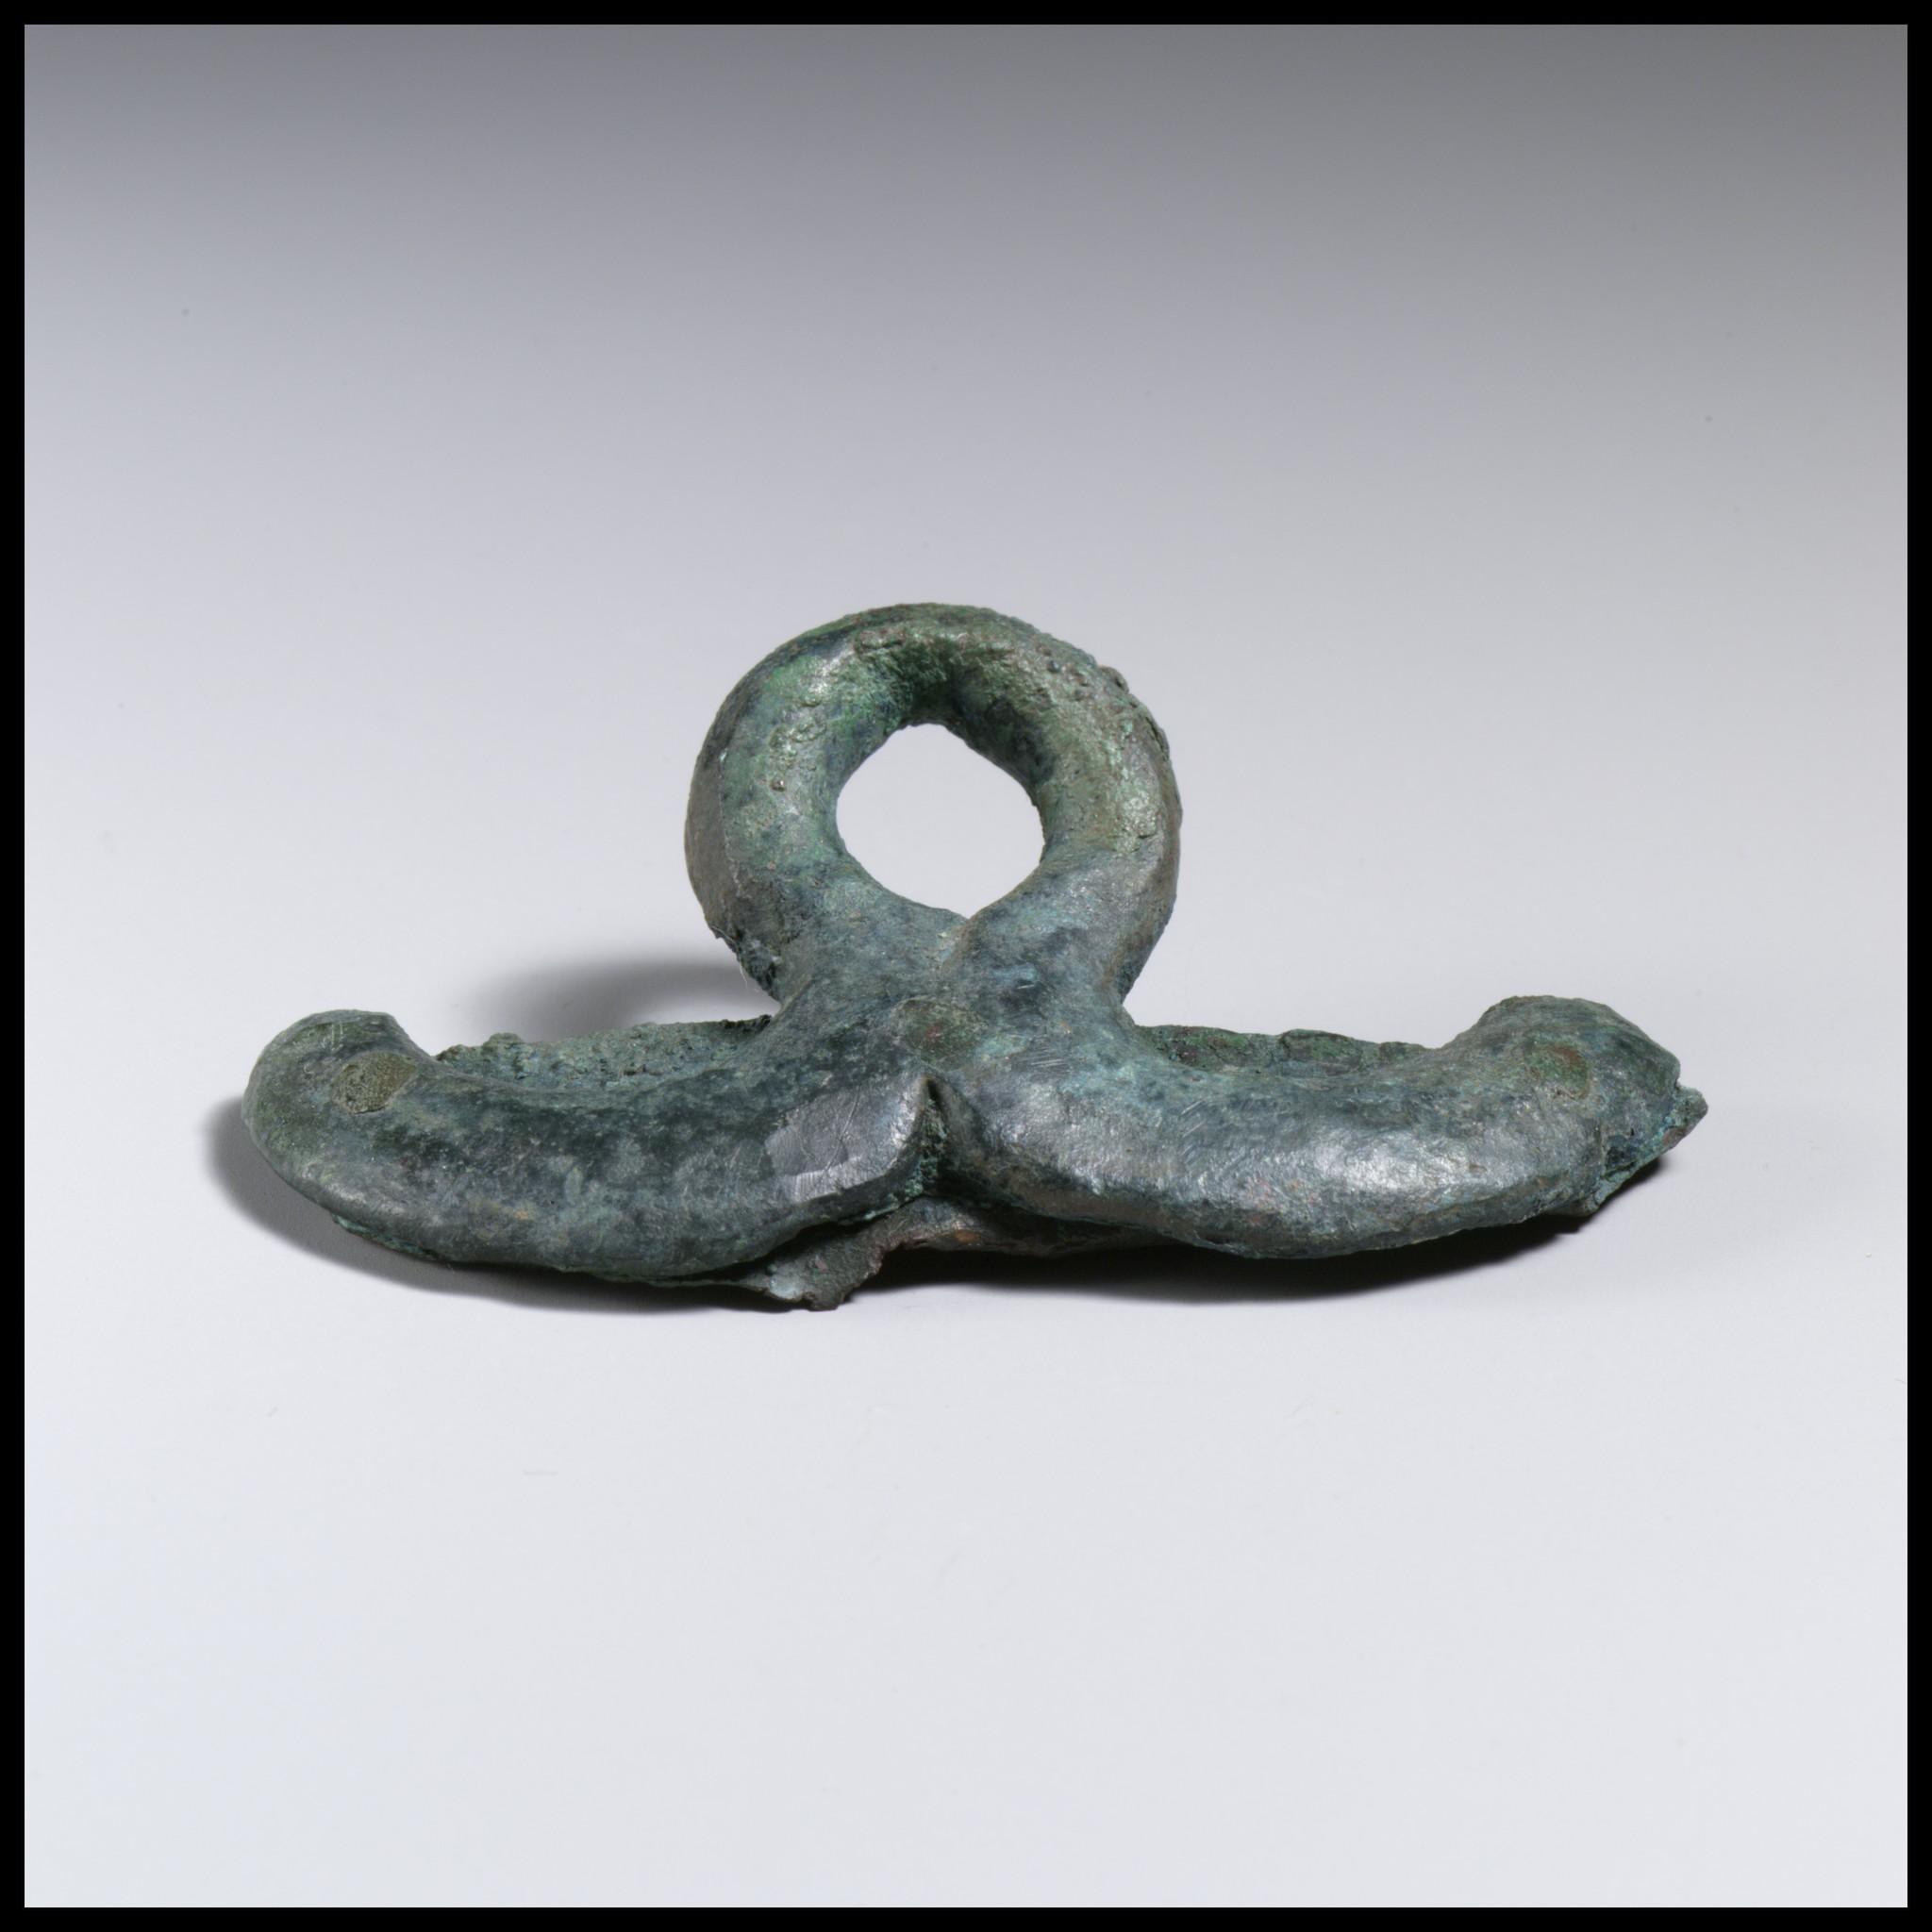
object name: handle attachment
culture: etruscan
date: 900-100 BCE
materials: bronze